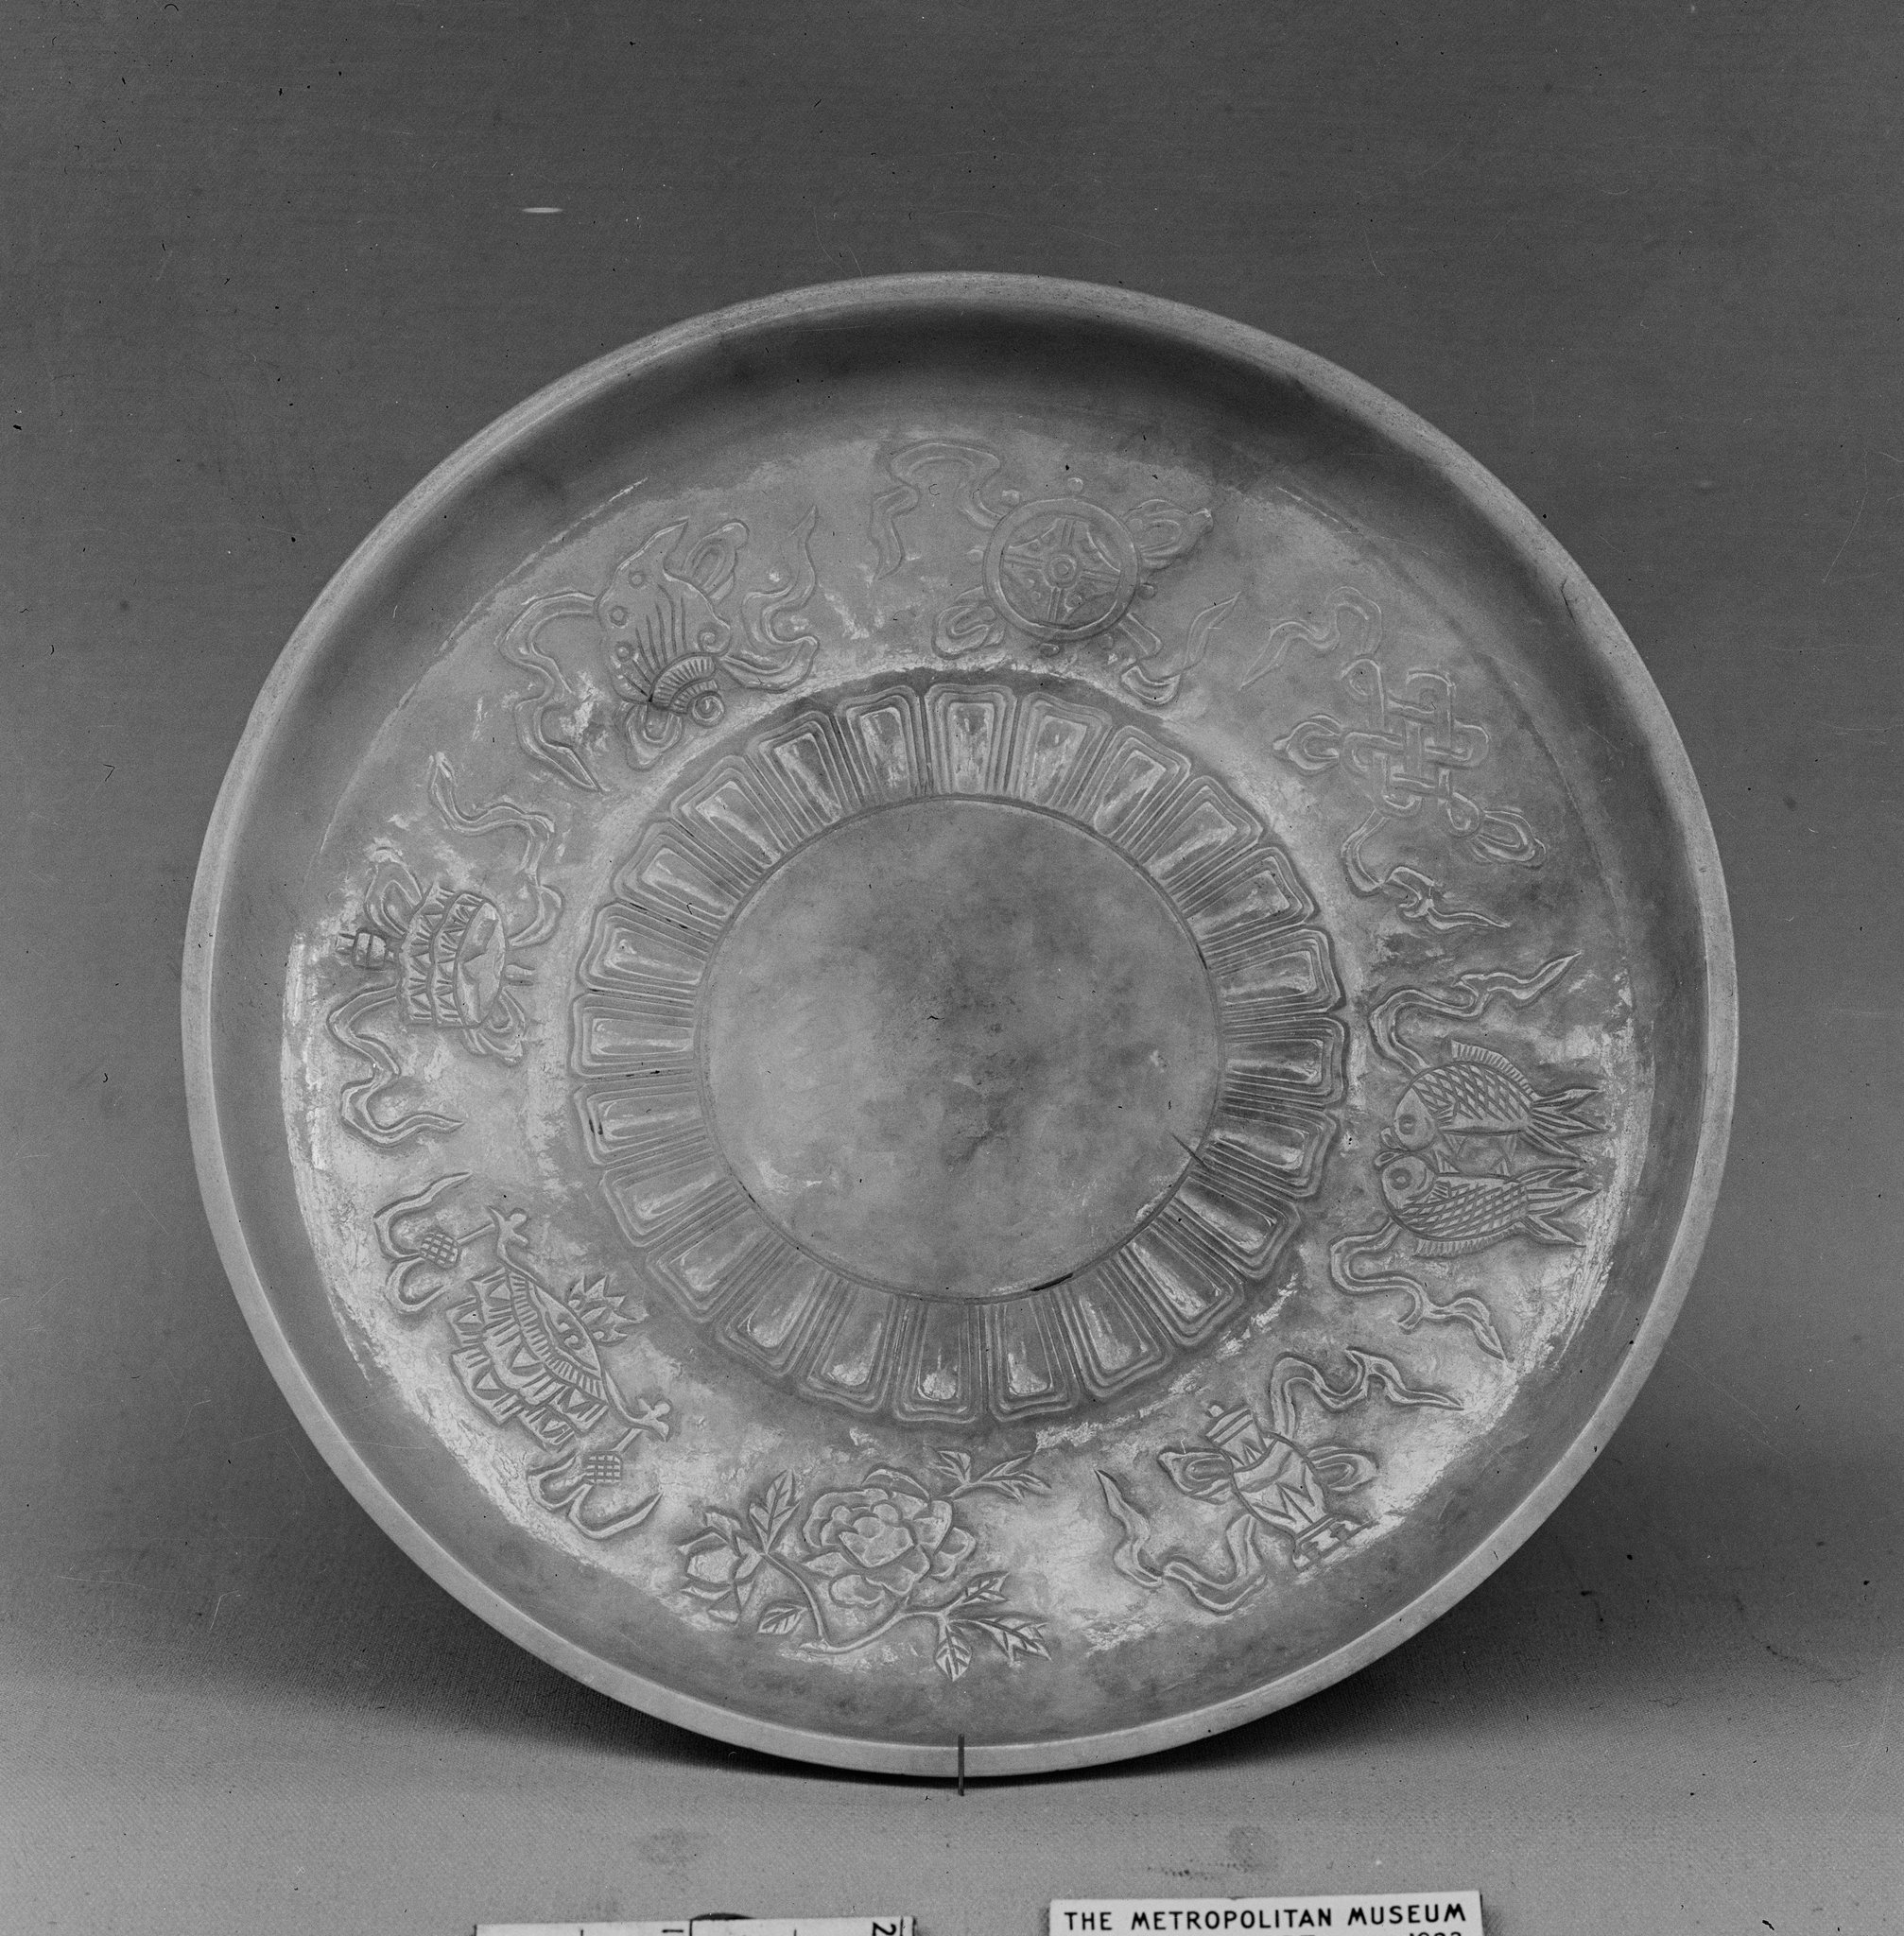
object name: dish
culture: chinese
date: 1736-1795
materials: jade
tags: fish,flowers